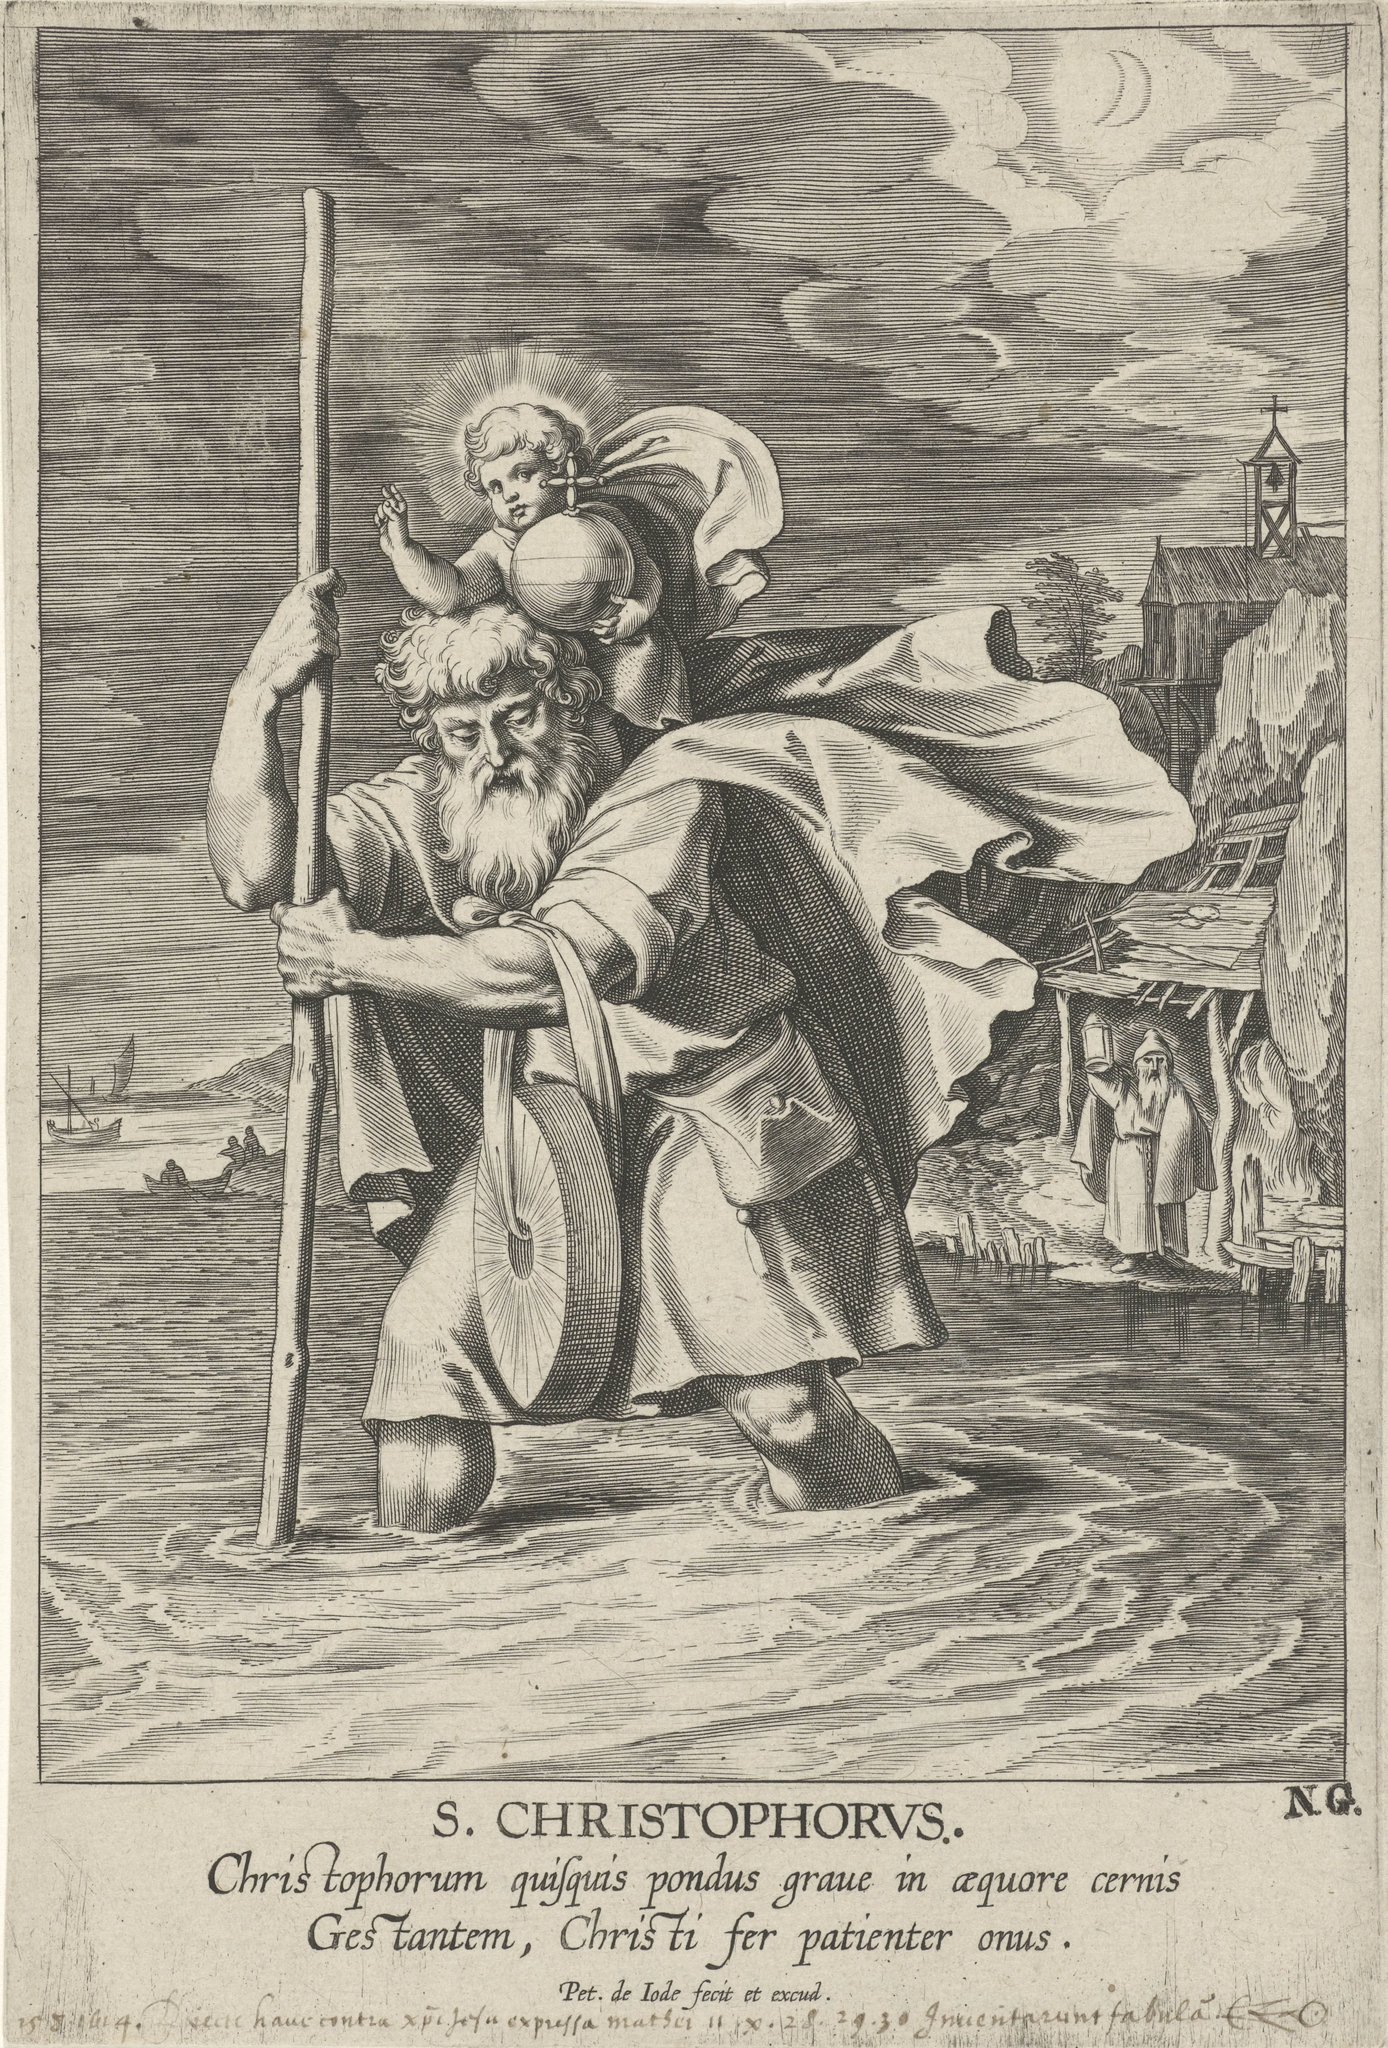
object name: print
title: De heilige Christoffel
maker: pieter de jode (i)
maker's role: draughtsman, print maker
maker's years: 1570-1634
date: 1590-1632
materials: paper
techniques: engraving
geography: antwerp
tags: st. christopher, with the infant christ on his shoulders, wading through the water and carrying his staff (palm-tree); sometimes a hermit stands on the further bank beside a chapel, a lantern in his hand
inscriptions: collector's mark: Lugt 1967, inscription, collector's mark: Lugt 2228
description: Landschap met de heilige Christoffel die met een kind op zijn rug het water doorwaadt . Aan zijn linkerarm hangt een schijf. Op de achtergrond staat een kluizenaar met een lantaarn op de oever. In de marge de naam van de heilige en een tweeregelig onderschrift in het Latijn.